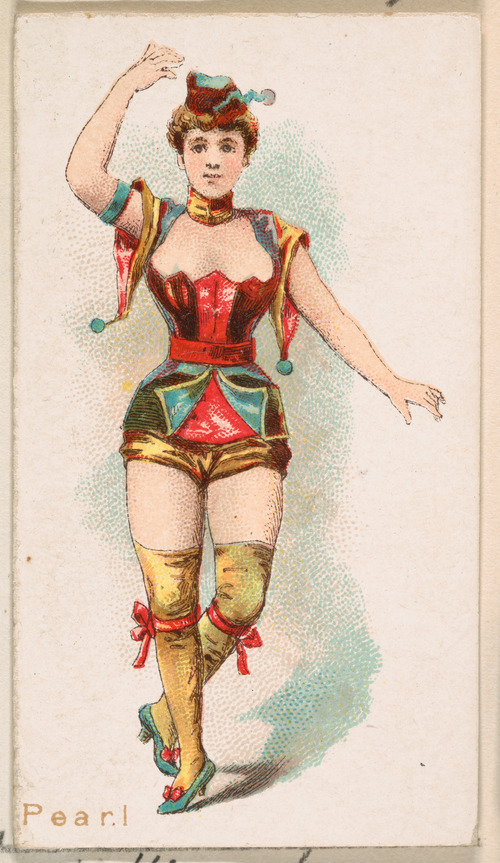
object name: print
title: Pearl, from the Ballet Queens series (N182) issued by Wm. S. Kimball & Co.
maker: william s. kimball & company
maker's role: publisher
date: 1889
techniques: color lithograph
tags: dance,women,dancers